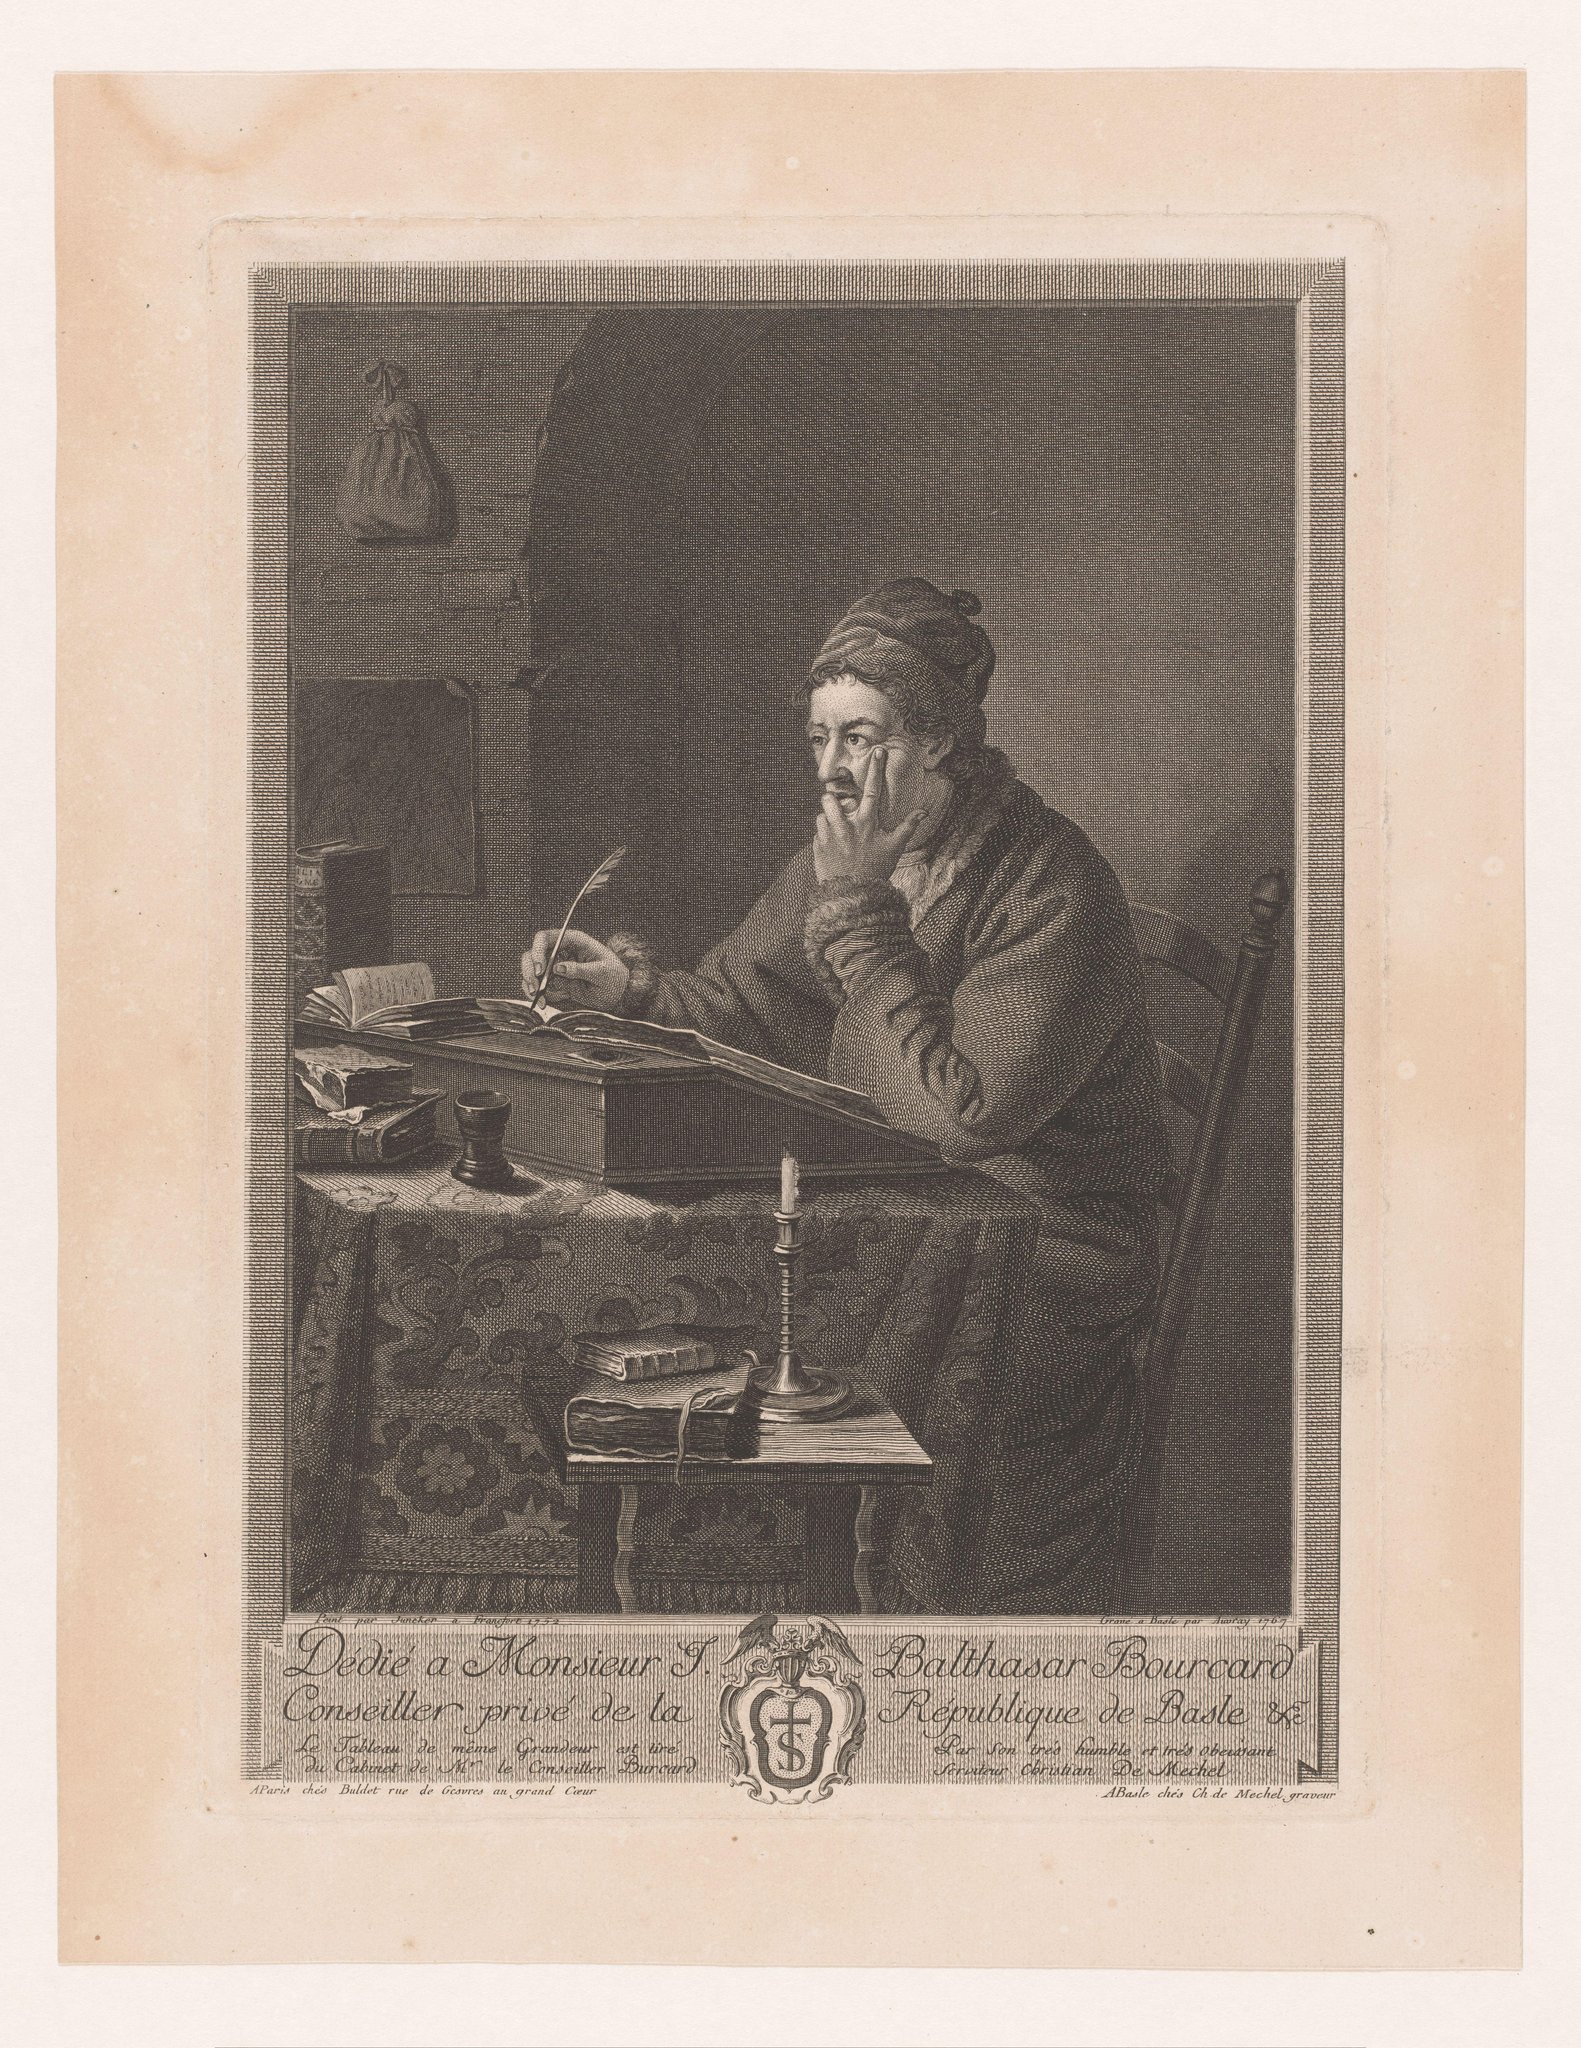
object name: print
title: Portret van Johann Balthasar Burckhardt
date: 1767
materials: paper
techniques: etching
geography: basel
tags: purse, money-bag, book, candle, author, poet writing, armorial bearing, heraldry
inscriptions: collector's mark: Lugt 2228